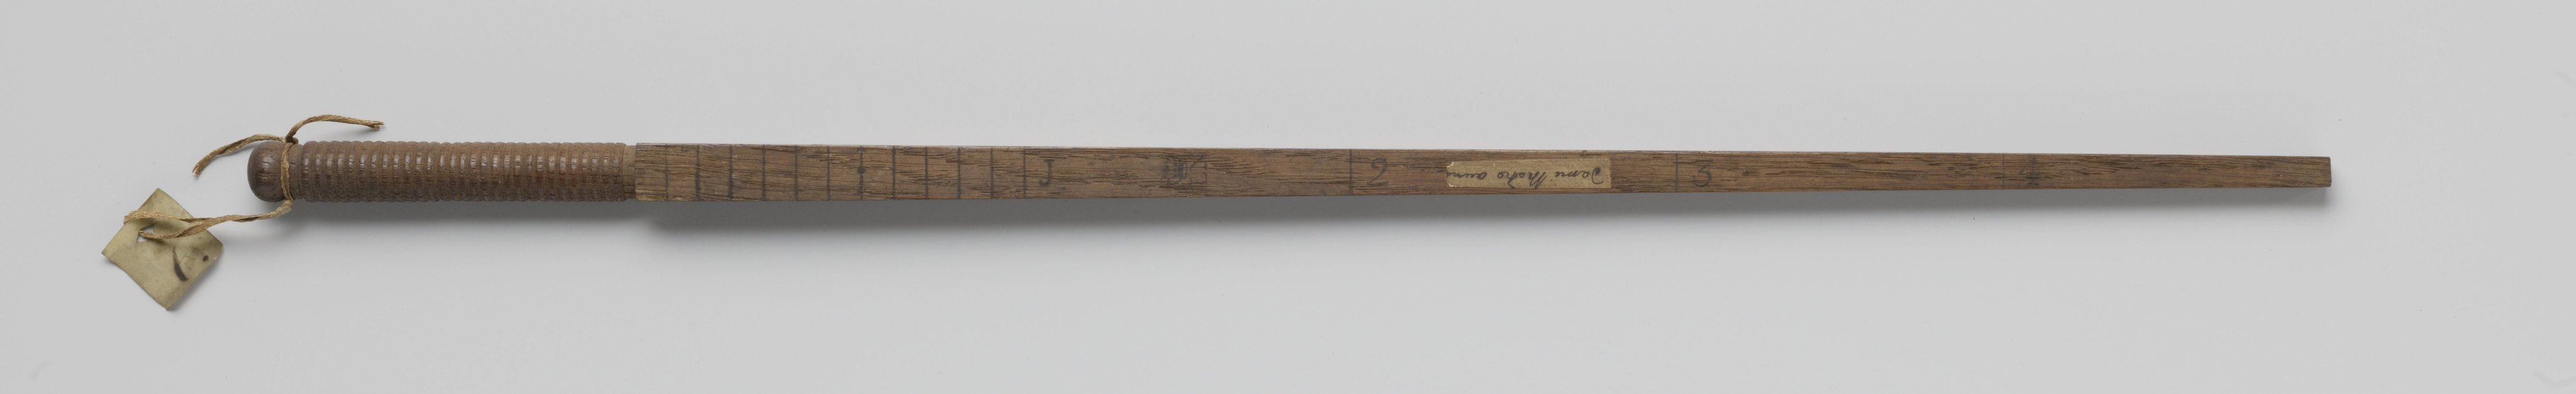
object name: meter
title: Halve meter met handvat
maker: Anonymous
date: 1820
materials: wood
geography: netherlands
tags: netherlands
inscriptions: inscription: ‘demi Mètre aune’, mark: ‘LN’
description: Halve meter met verdeling en becijfering in decimeters. Eerste decimeter in centimeters. V.z.v. etiket en merk